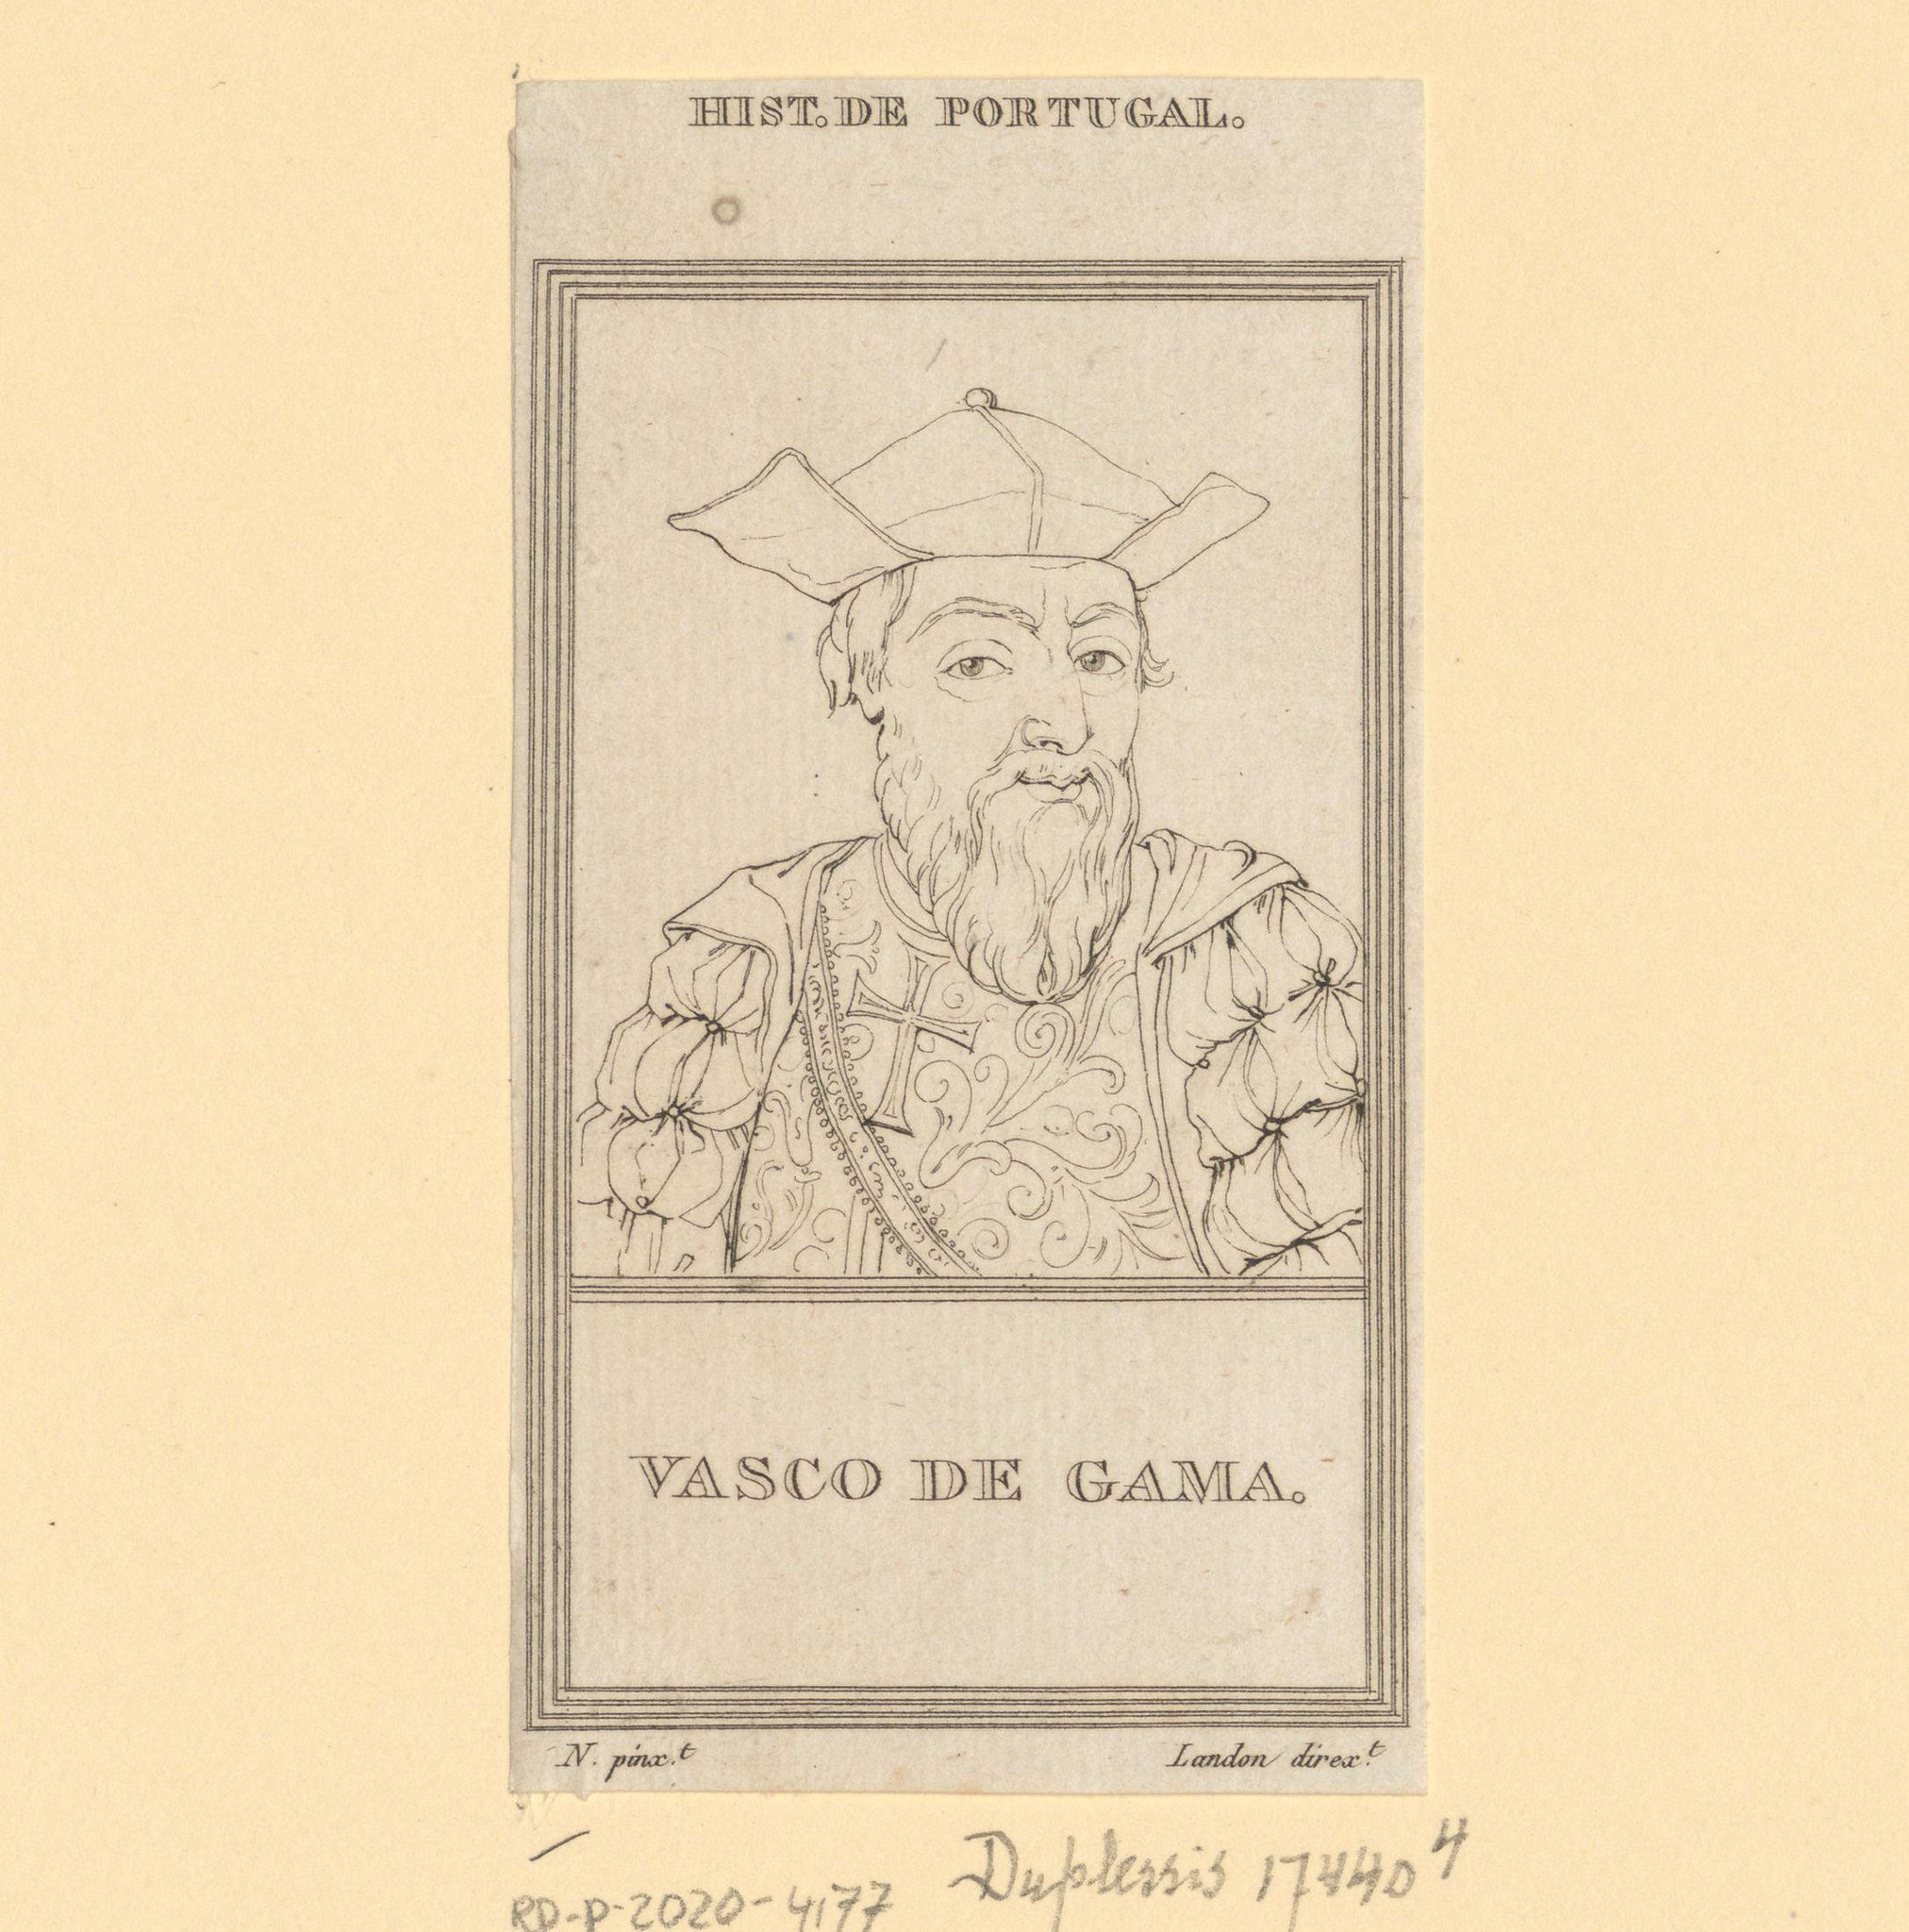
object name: print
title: Portret van Vasco da Gama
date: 1805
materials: paper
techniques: etching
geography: paris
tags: historical persons, exploration, expedition, voyage of discovery (+ scholar, scientist in non-work situations)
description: Prent uit: Galerie historique des hommes les plus célèbres (...). Parijs: Charles Paul Landon, 1805, dl. 5.